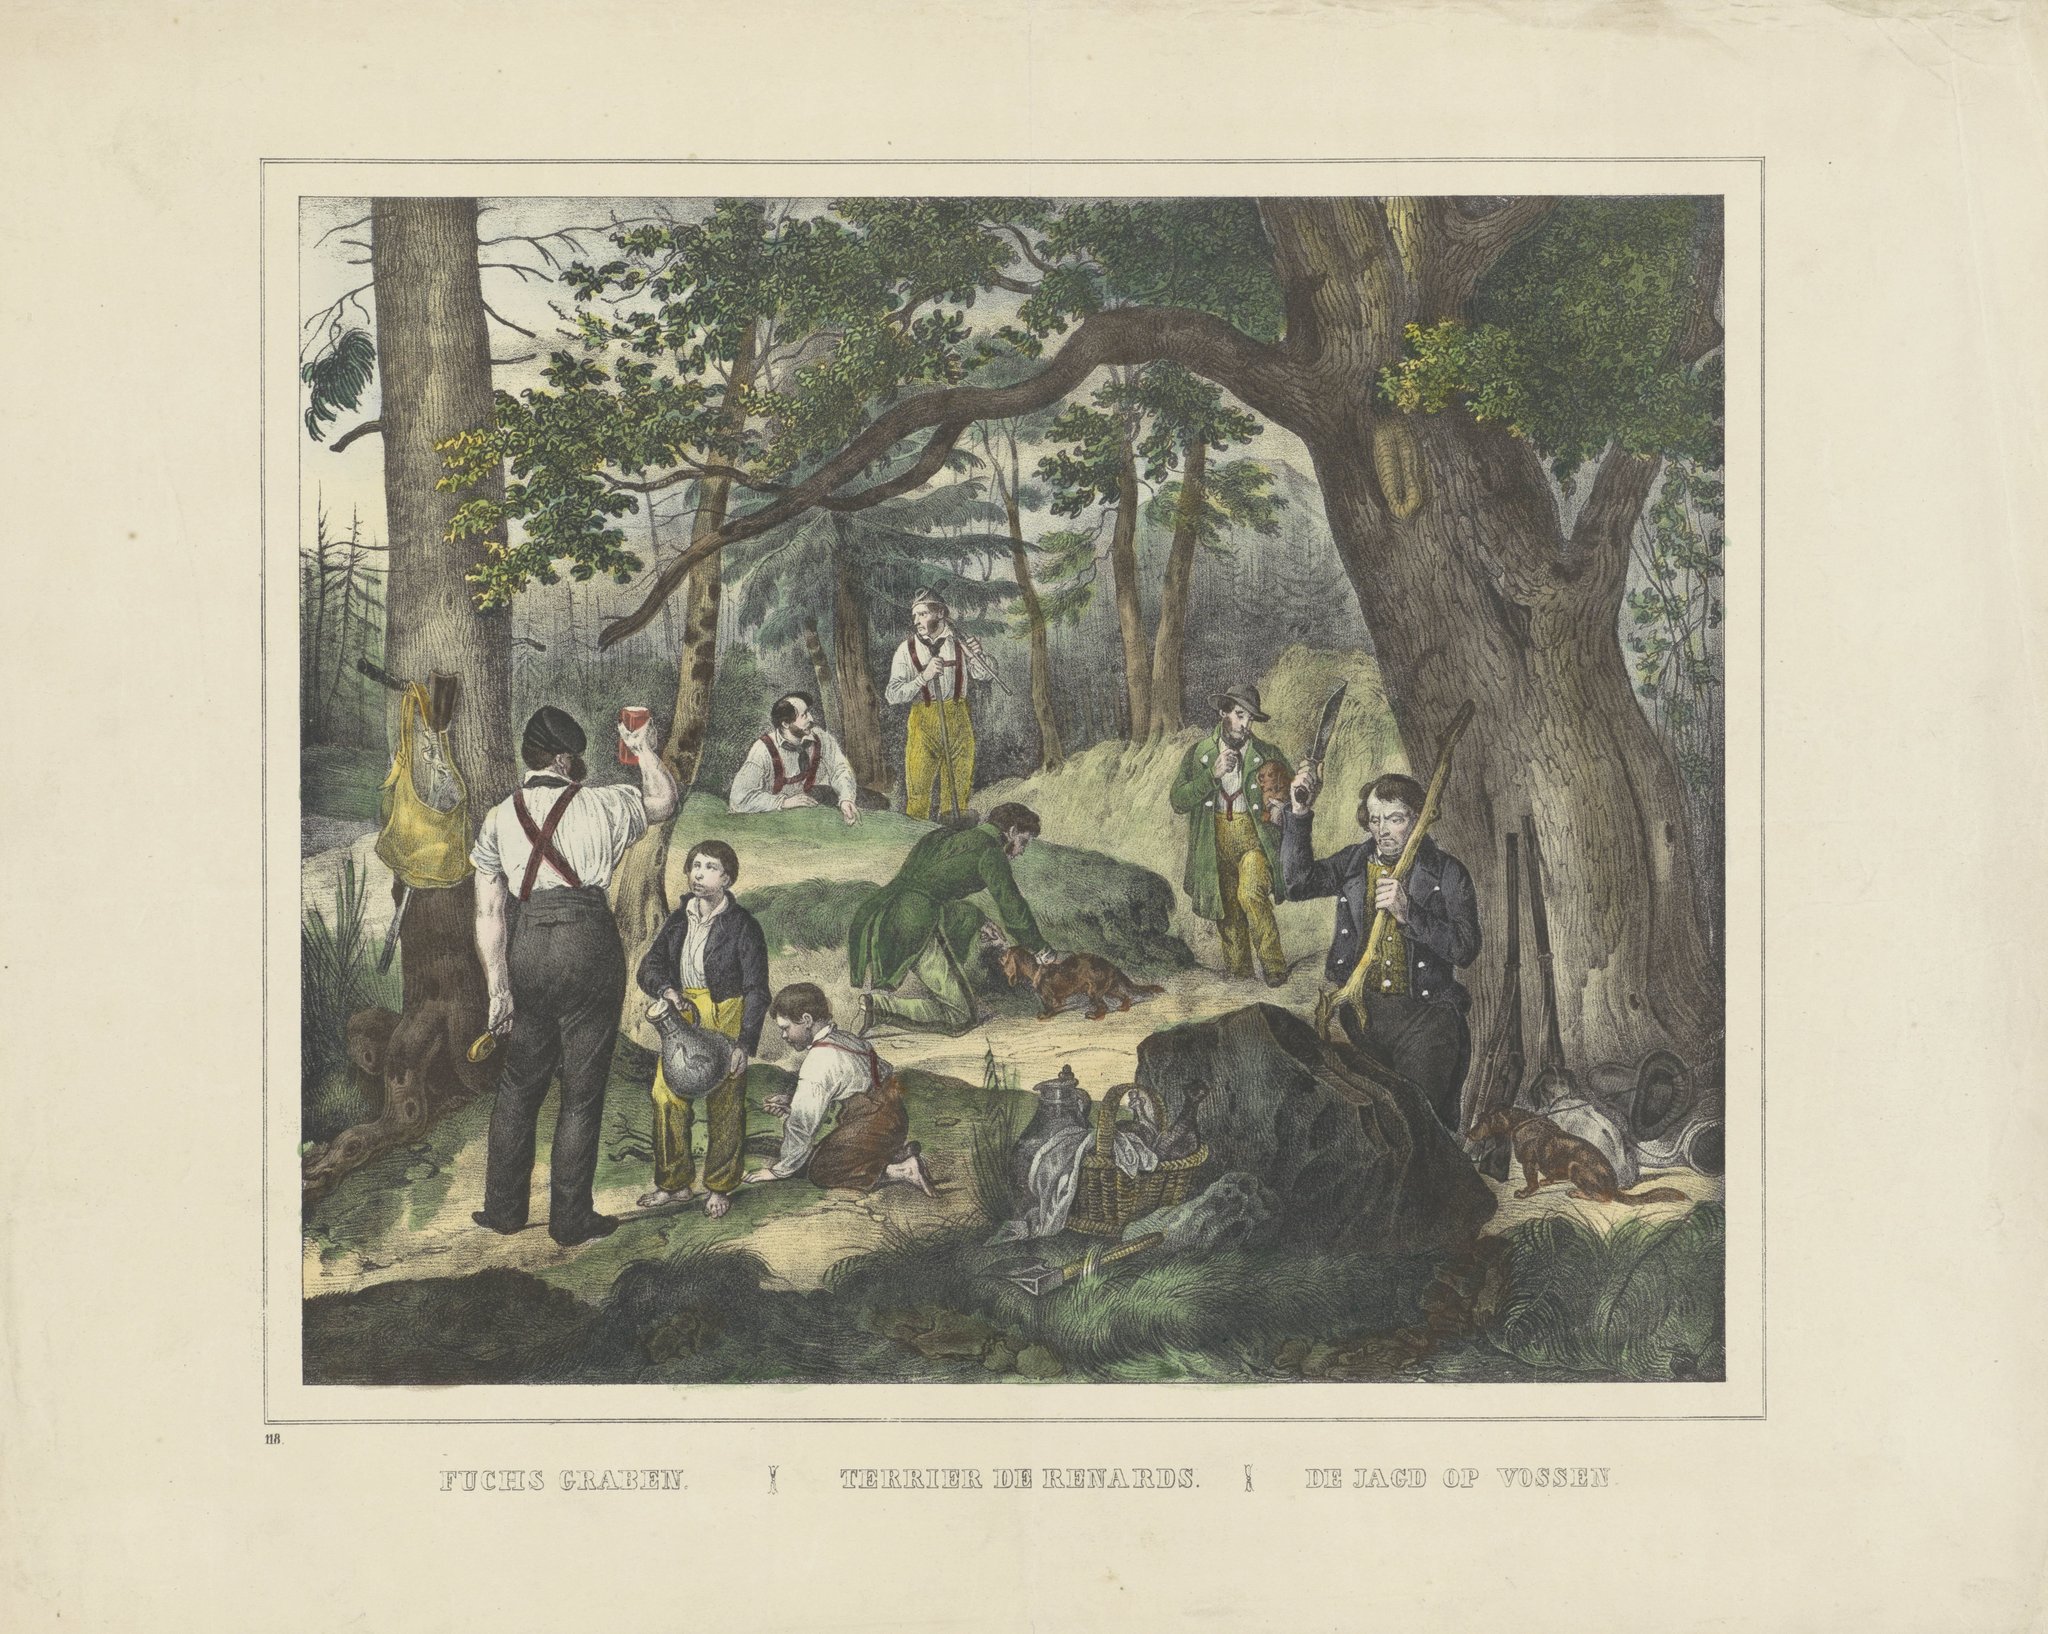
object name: popular print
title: Fuchs graben. / Terrier de renards. / De jagd op vossen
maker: Anonymous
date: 1829-1880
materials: paper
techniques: colour, lithograph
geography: germany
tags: hunters hunting (n.b.: in 1988-1990 this notation denoted the concept of 43c11421 'hunters resting during the hunt'), fox hunting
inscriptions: collector's mark: Lugt 2760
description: Een groep jagers met honden in het bos, bezig met het jagen op vossen. Genummerd linksonder: 118.